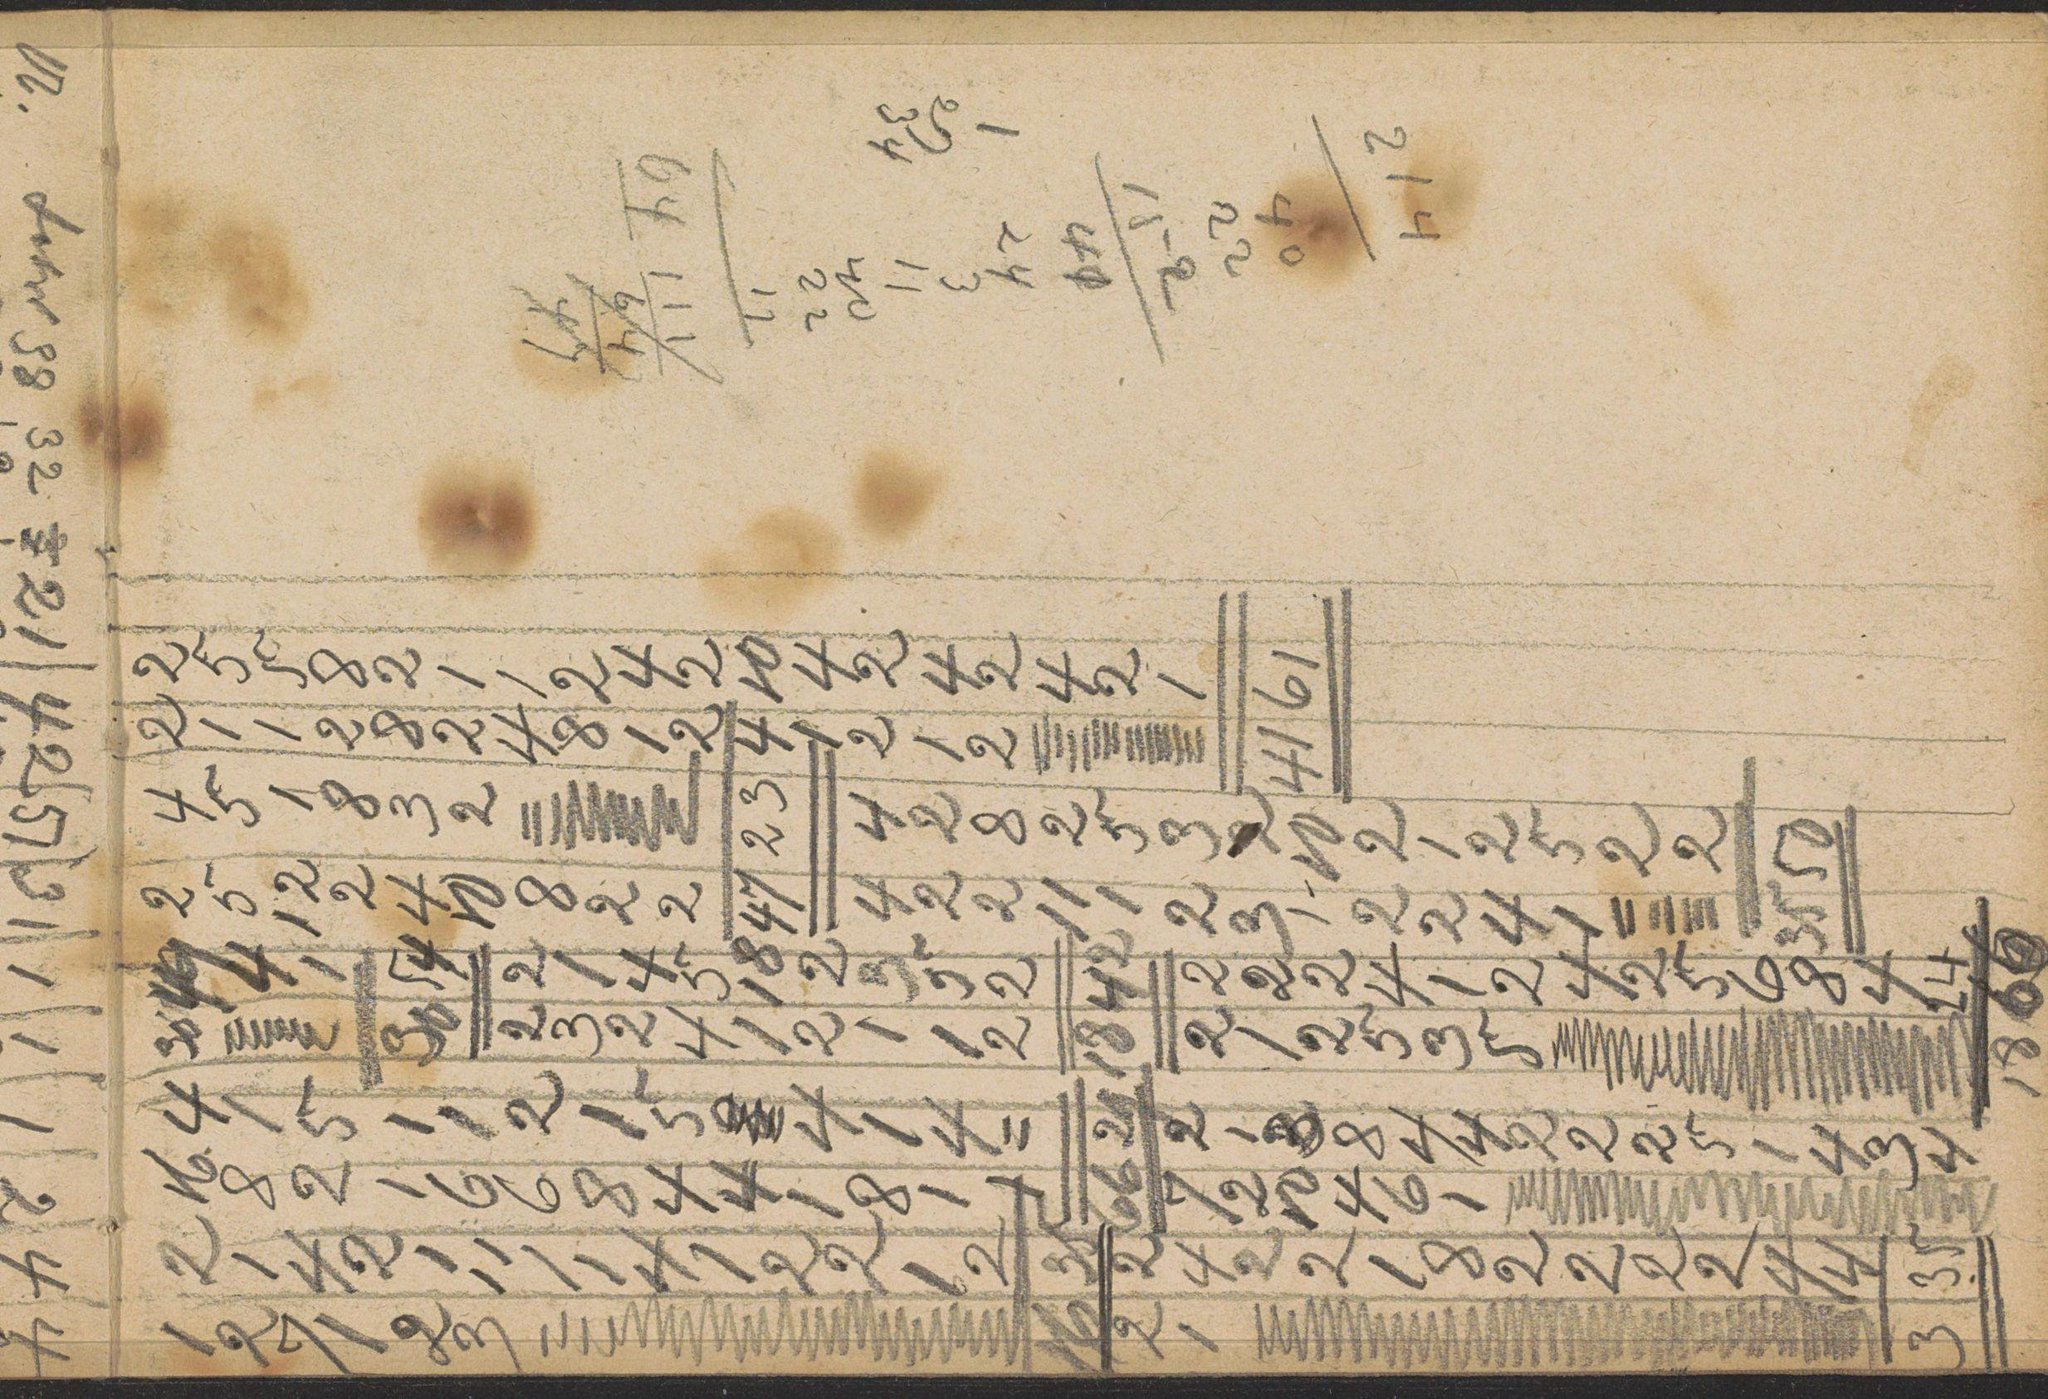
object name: endleaf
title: Getallenrijen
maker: willem witsen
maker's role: draughtsman, painter, print maker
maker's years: 1860-1923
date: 1887-1920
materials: paper, pencil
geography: amsterdam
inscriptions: annotation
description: Schutblad B, achterste schutblad, uit een schetsboek met 12 bladen.